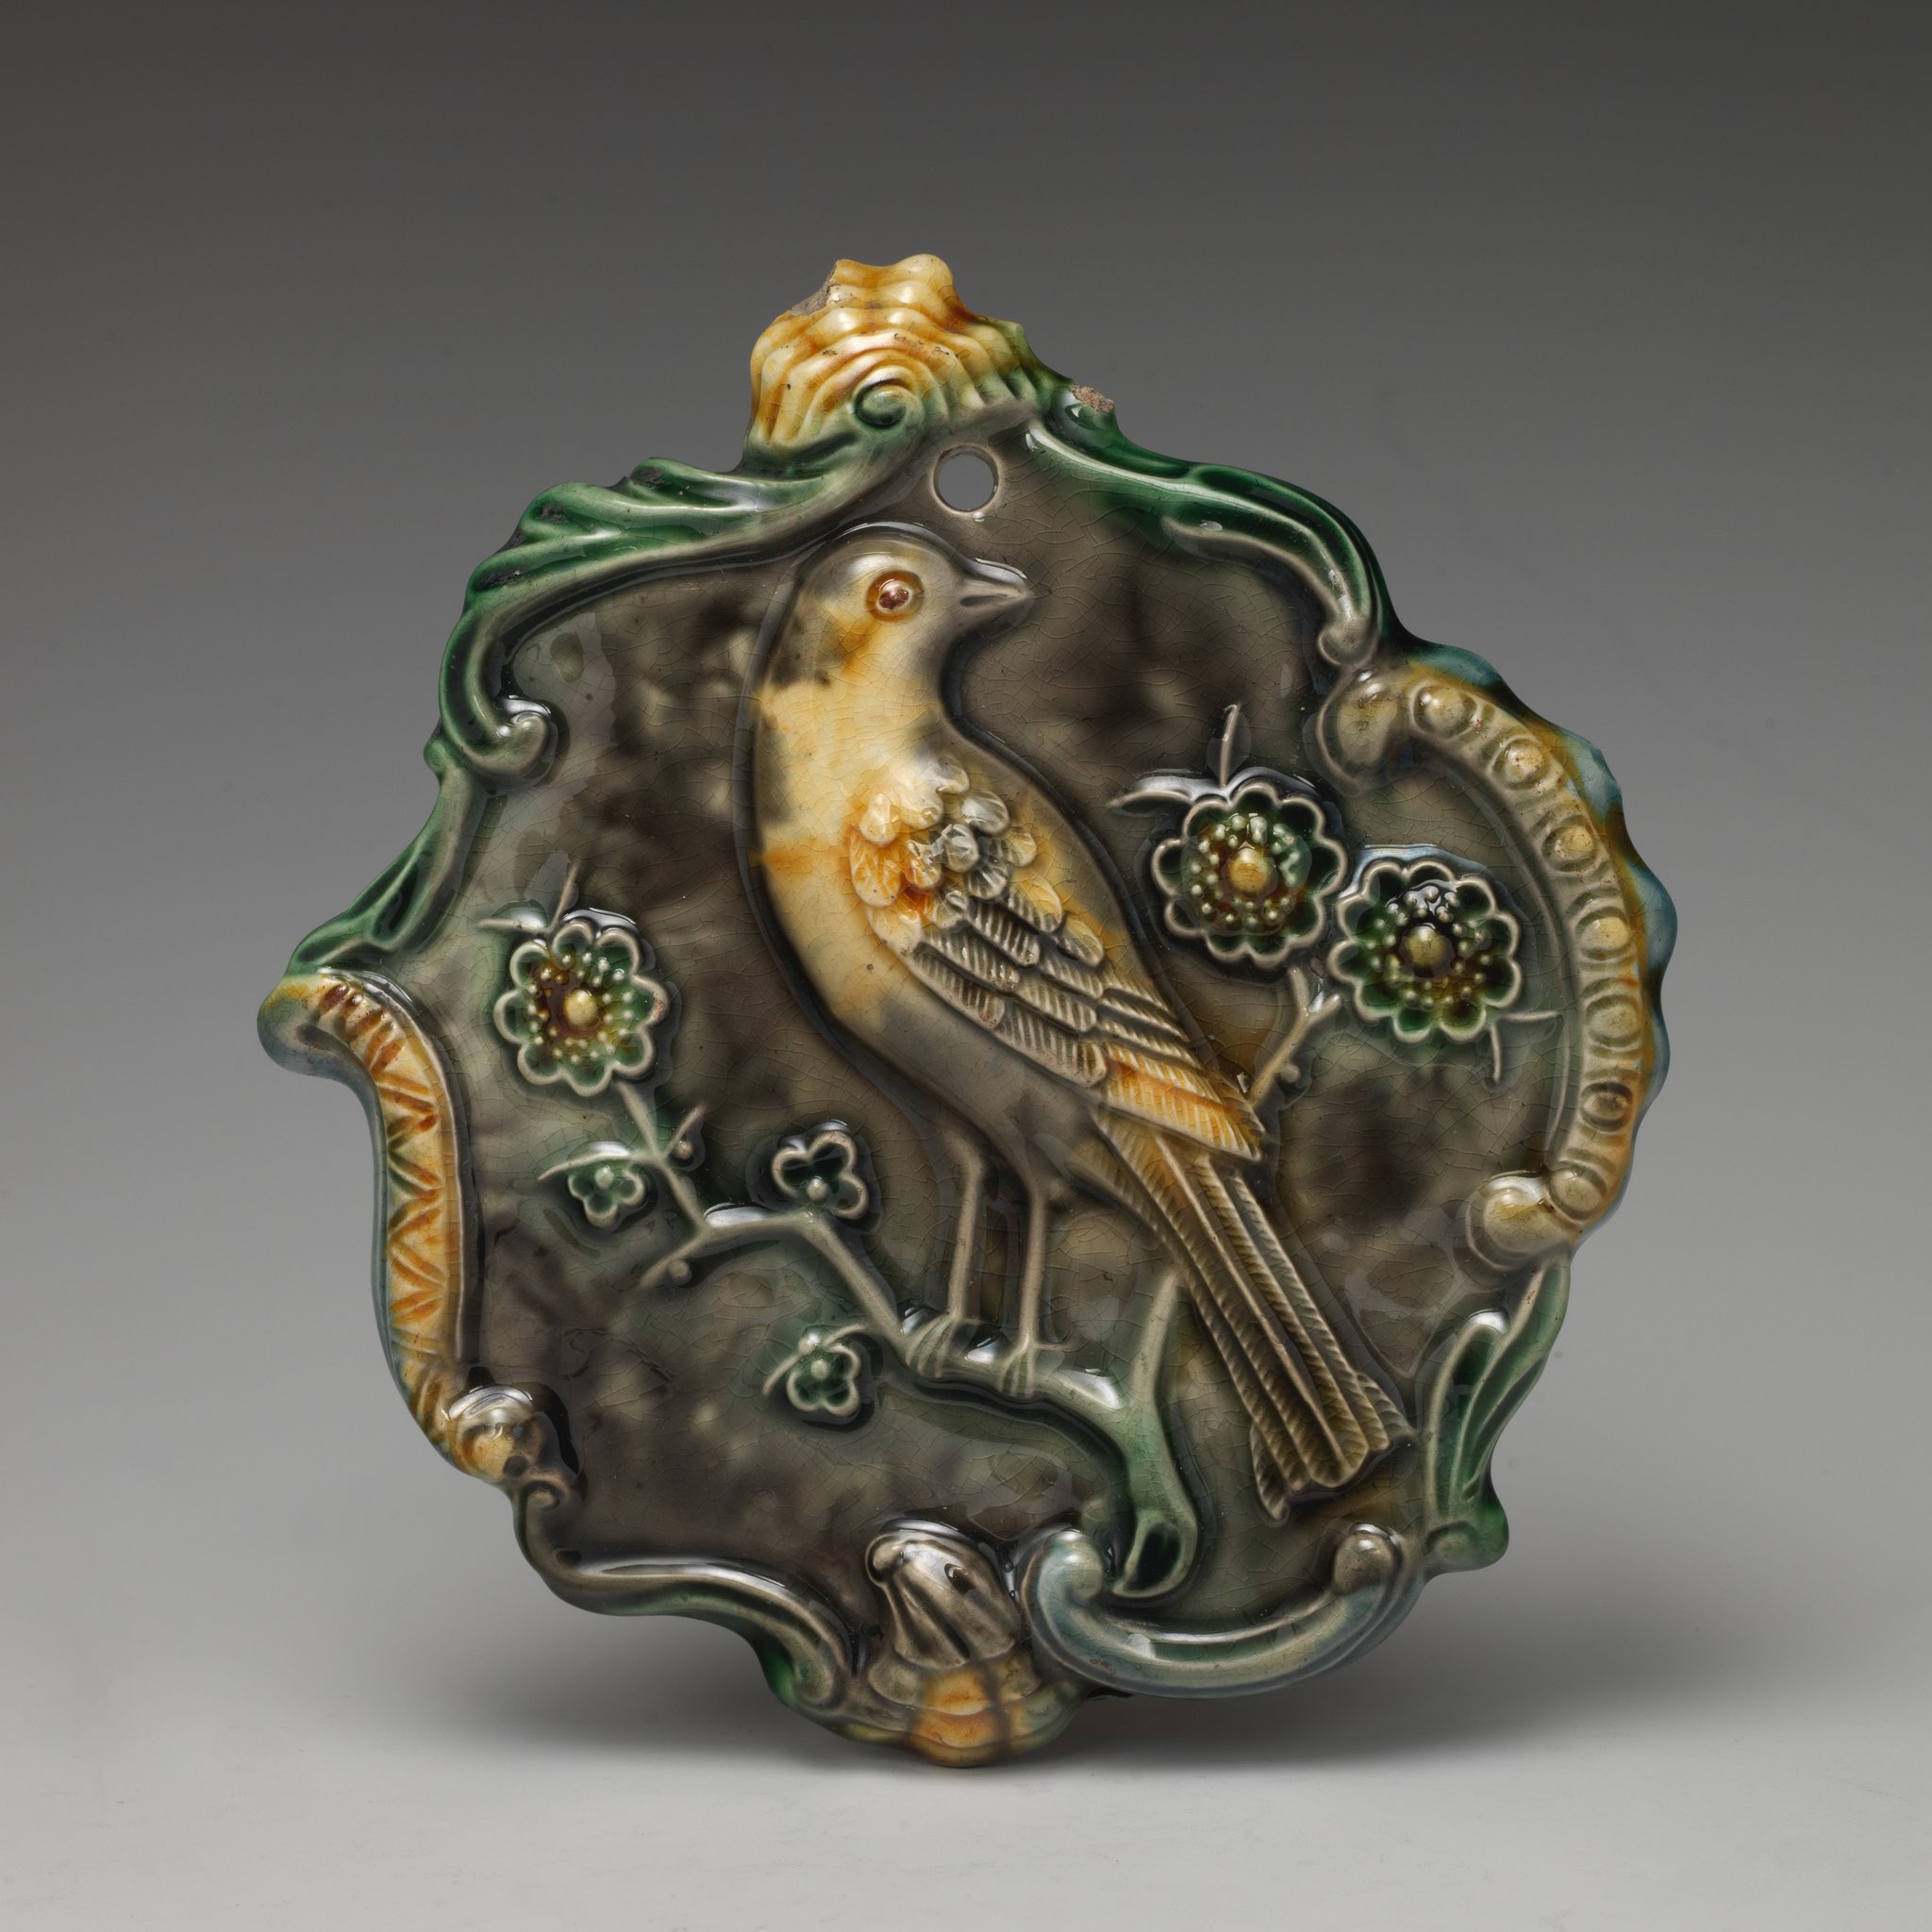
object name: plaque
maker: whieldon type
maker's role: maker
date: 1760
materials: earthenware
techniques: glazing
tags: birds,flowers